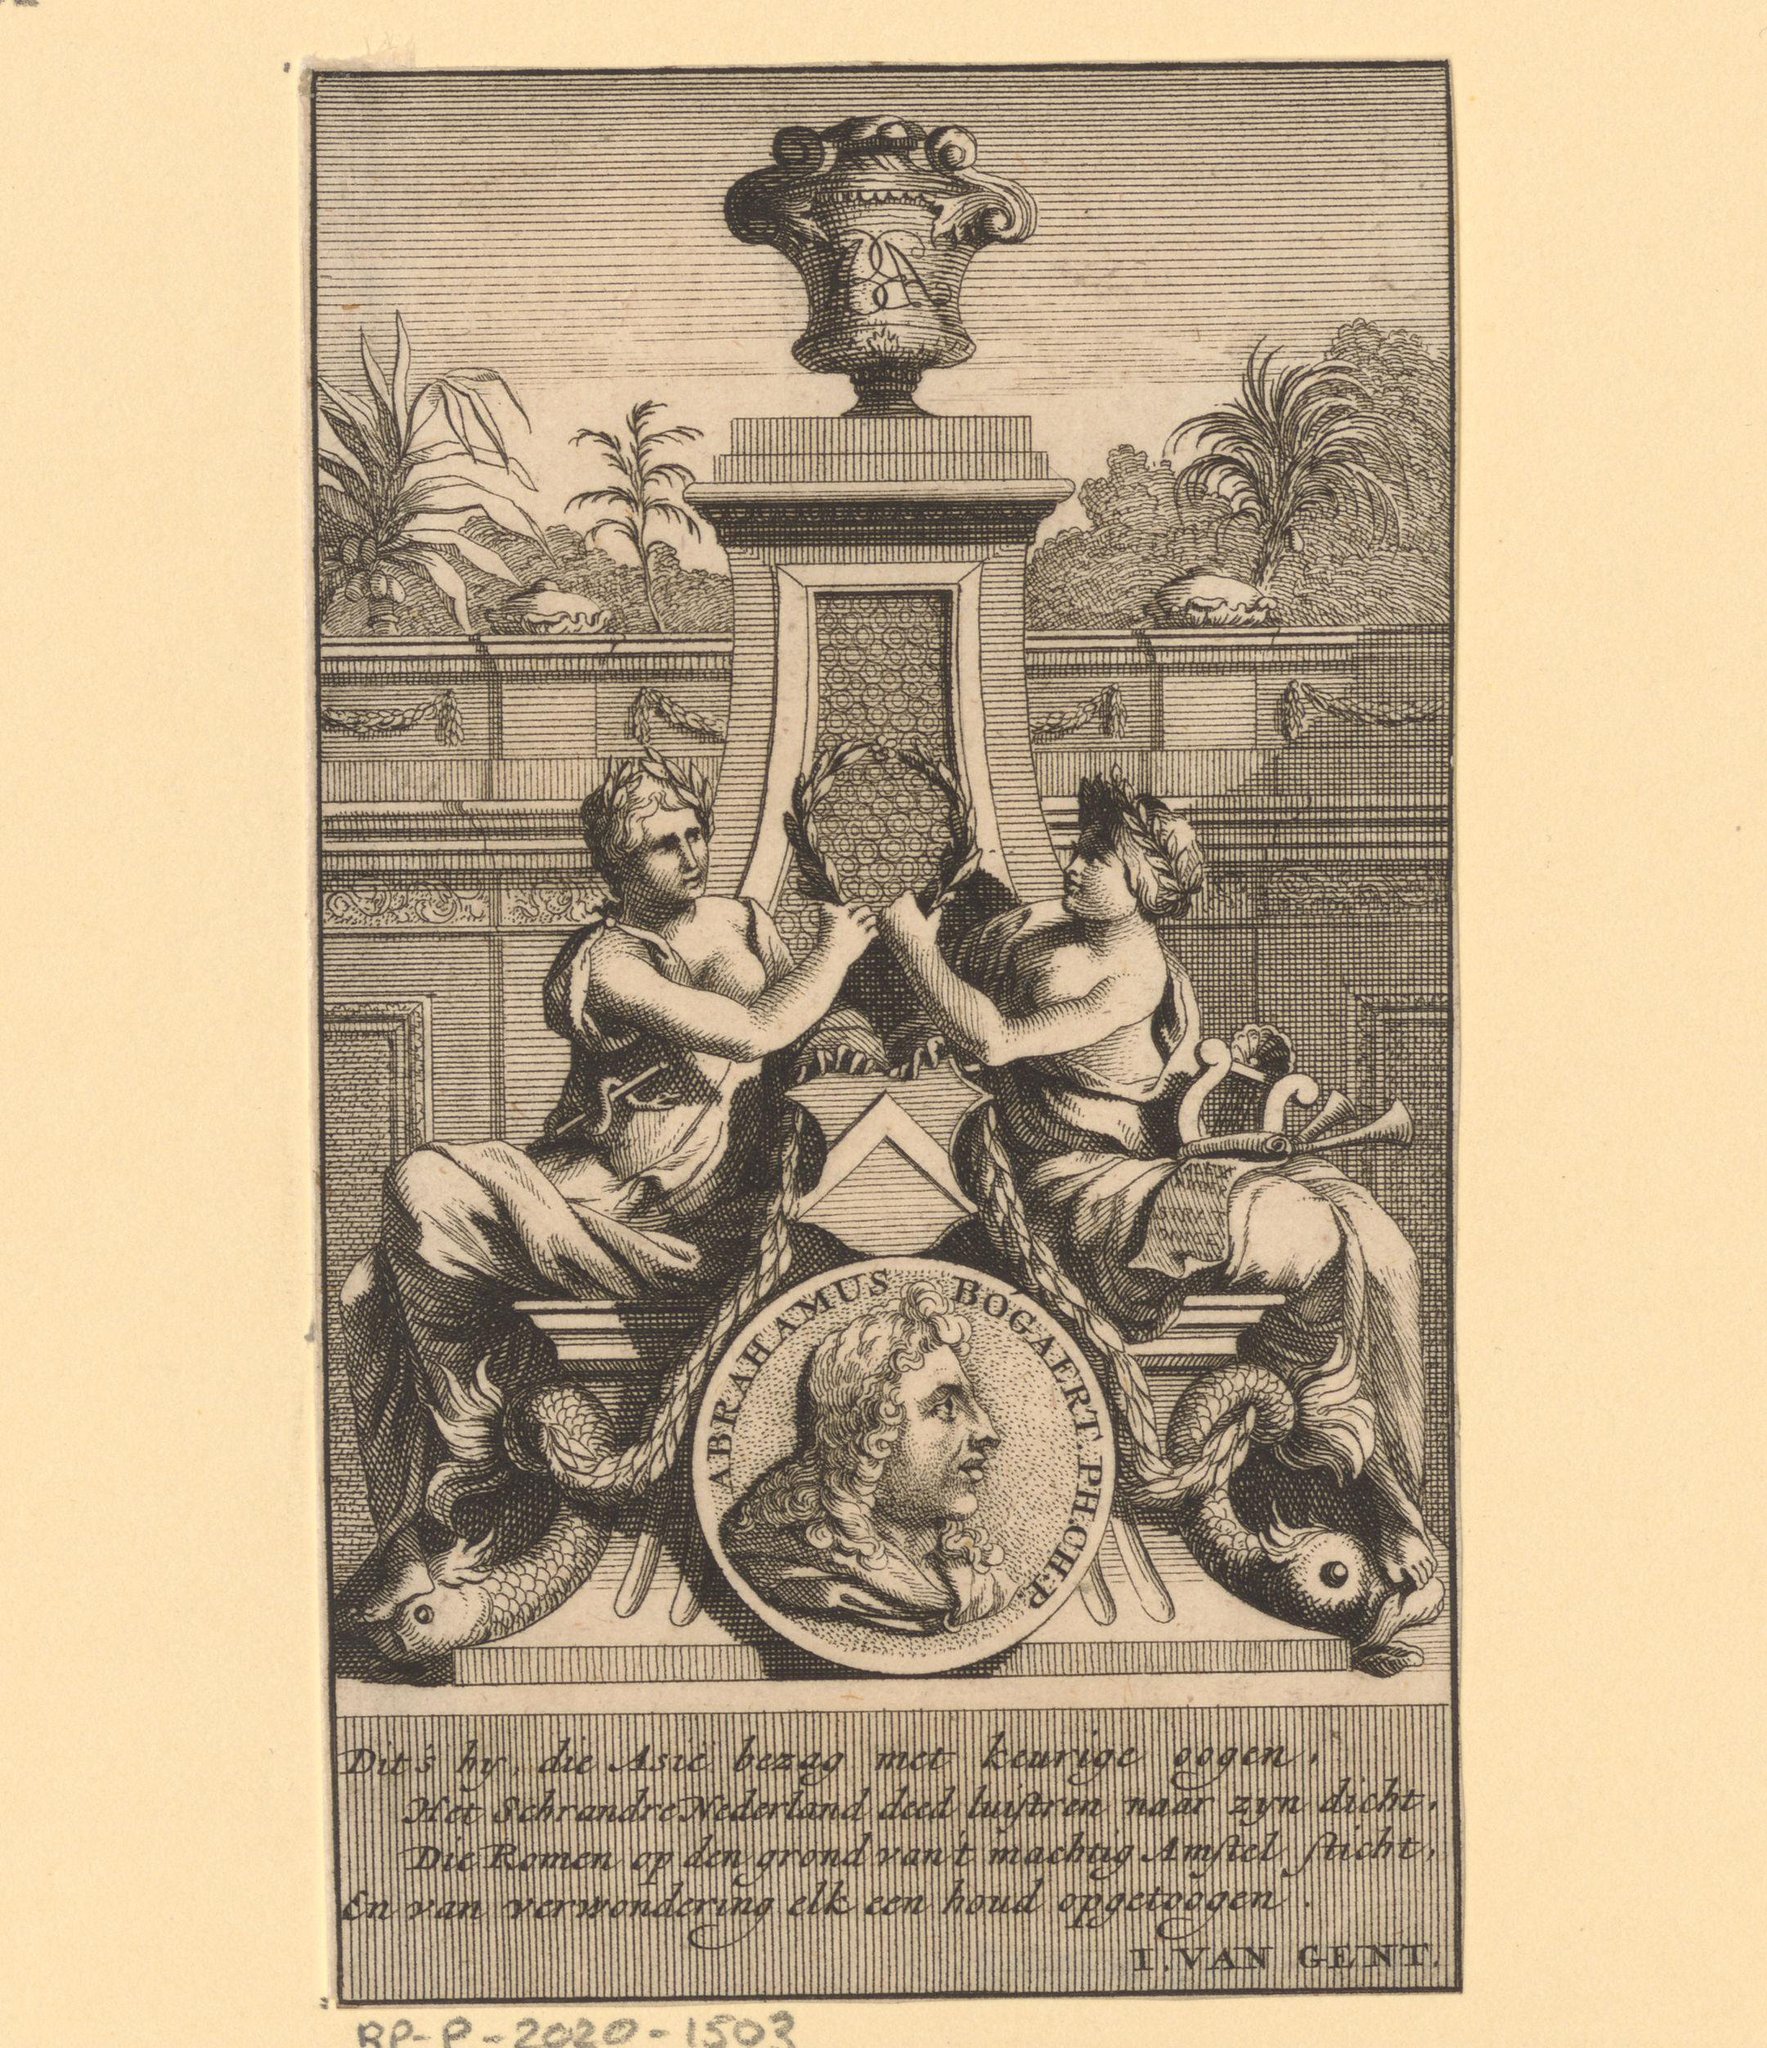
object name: print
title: Monument met portret van Abraham Bogaert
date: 1700-1799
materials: paper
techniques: engraving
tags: abraham bogaert, historical persons, portrait of a writer, monument, statue, armorial bearing, heraldry